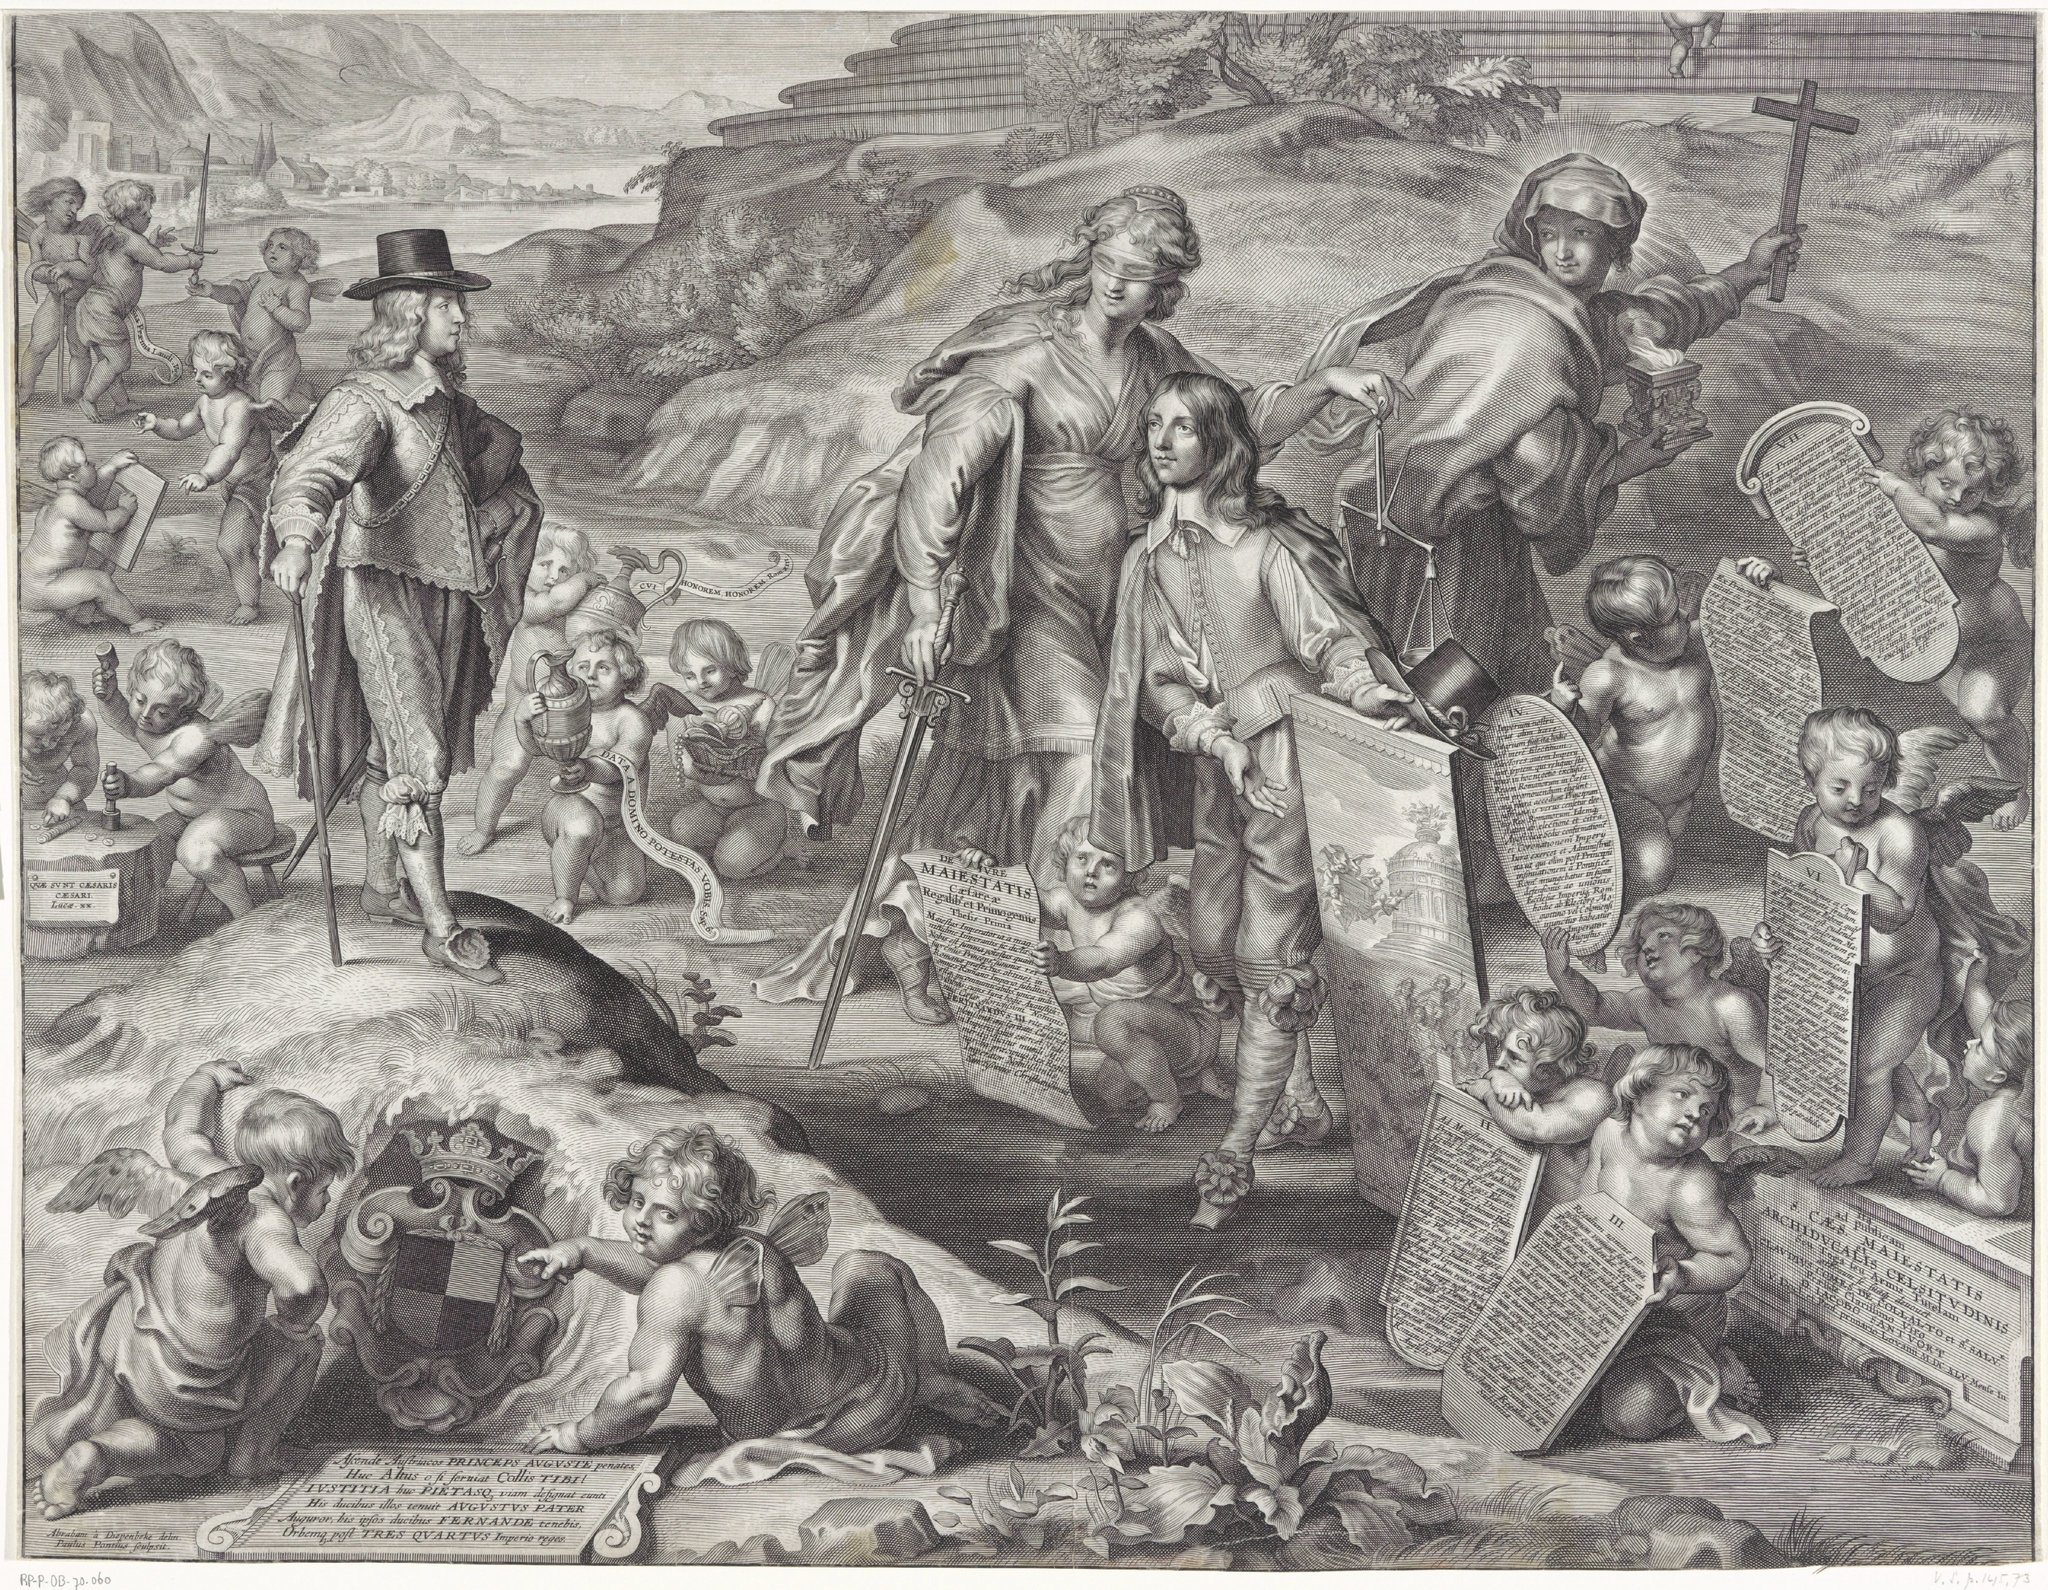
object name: promotieprent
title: Promotieprent van Claudius von Collalto (1645), onderste deel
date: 1645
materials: paper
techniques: engraving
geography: antwerp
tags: justice, 'justitia'; 'giustitia divina' (ripa) ~ one of the four cardinal virtues, faith, 'fides'; 'fede', 'fede catholica', 'fede christiana', 'fede christiana catholica' (ripa) ~ one of the three theological virtues, armorial bearing, heraldry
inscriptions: collector's mark: Lugt 240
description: Landschap met Rechtvaardigheid en Geloof, vergezeld door putti met tabletten waarop de te verdedigen standpunten in het Latijn. In het midden staat een jonge man met het ontwerp van de promotieprent. Een rijke heer op een heuvel aan de linkerzijde slaat het tafereel gade, putti bieden hem geschenken aan. Achter hem putti die munten slaan, tekenen en vechten met een zwaard. Rechts op een ornament de aankondiging van de promotie aan de universiteit van Leuven, met professor Jacob van Santvoort als promotor. Links op de voorgrond twee putti bij het wapenschild van Claudius von Collalto.